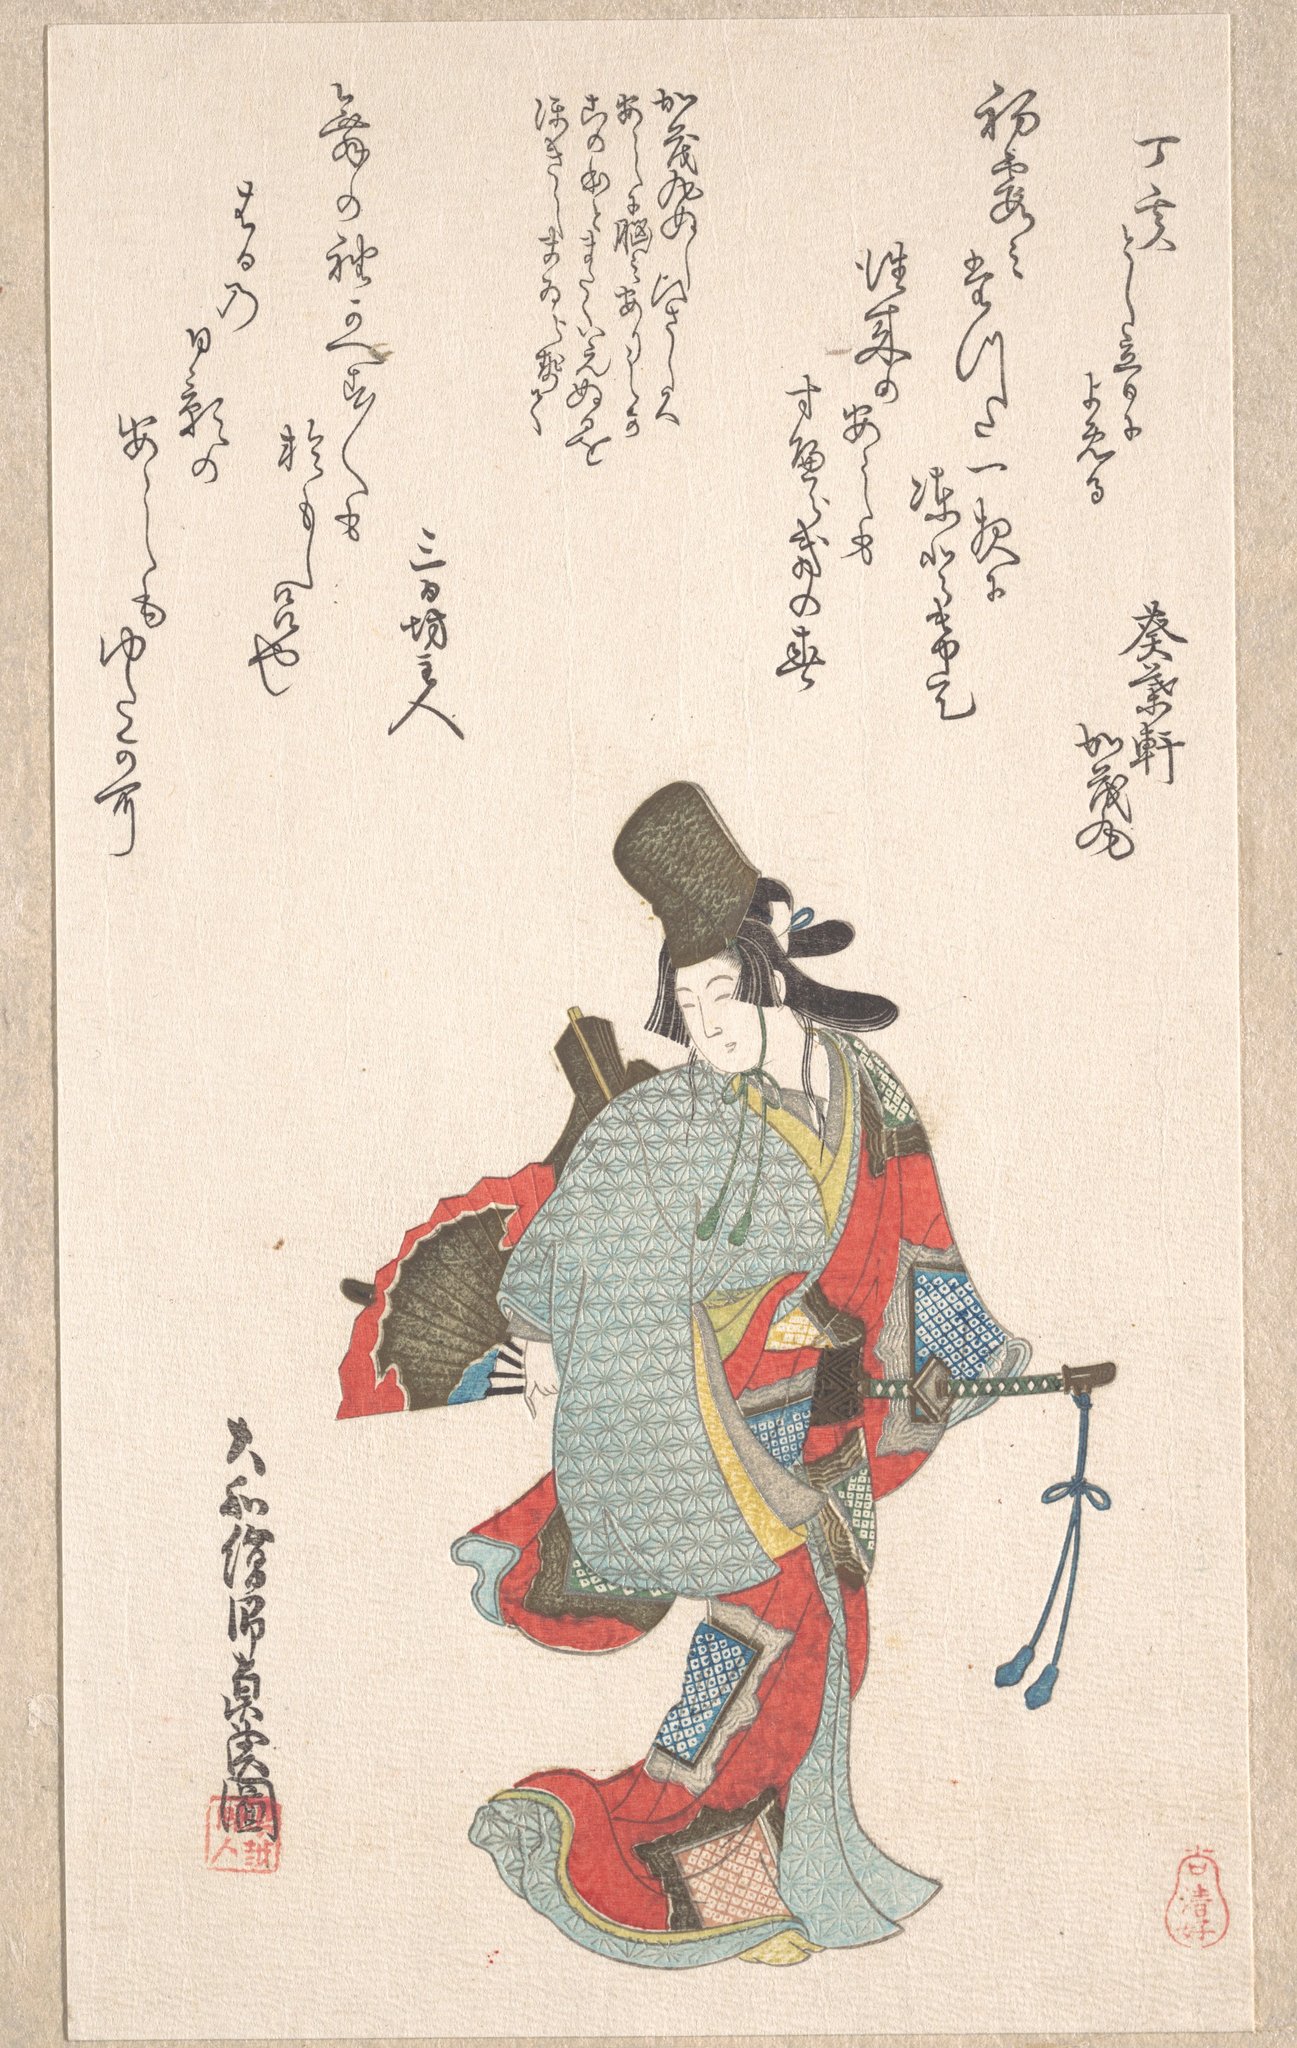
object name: print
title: Dancer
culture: japanese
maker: oishi matora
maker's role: artist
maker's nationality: japanese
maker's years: 1793-1833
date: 1827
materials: ink, paper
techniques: surimono, woodblock print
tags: human figures,dancers